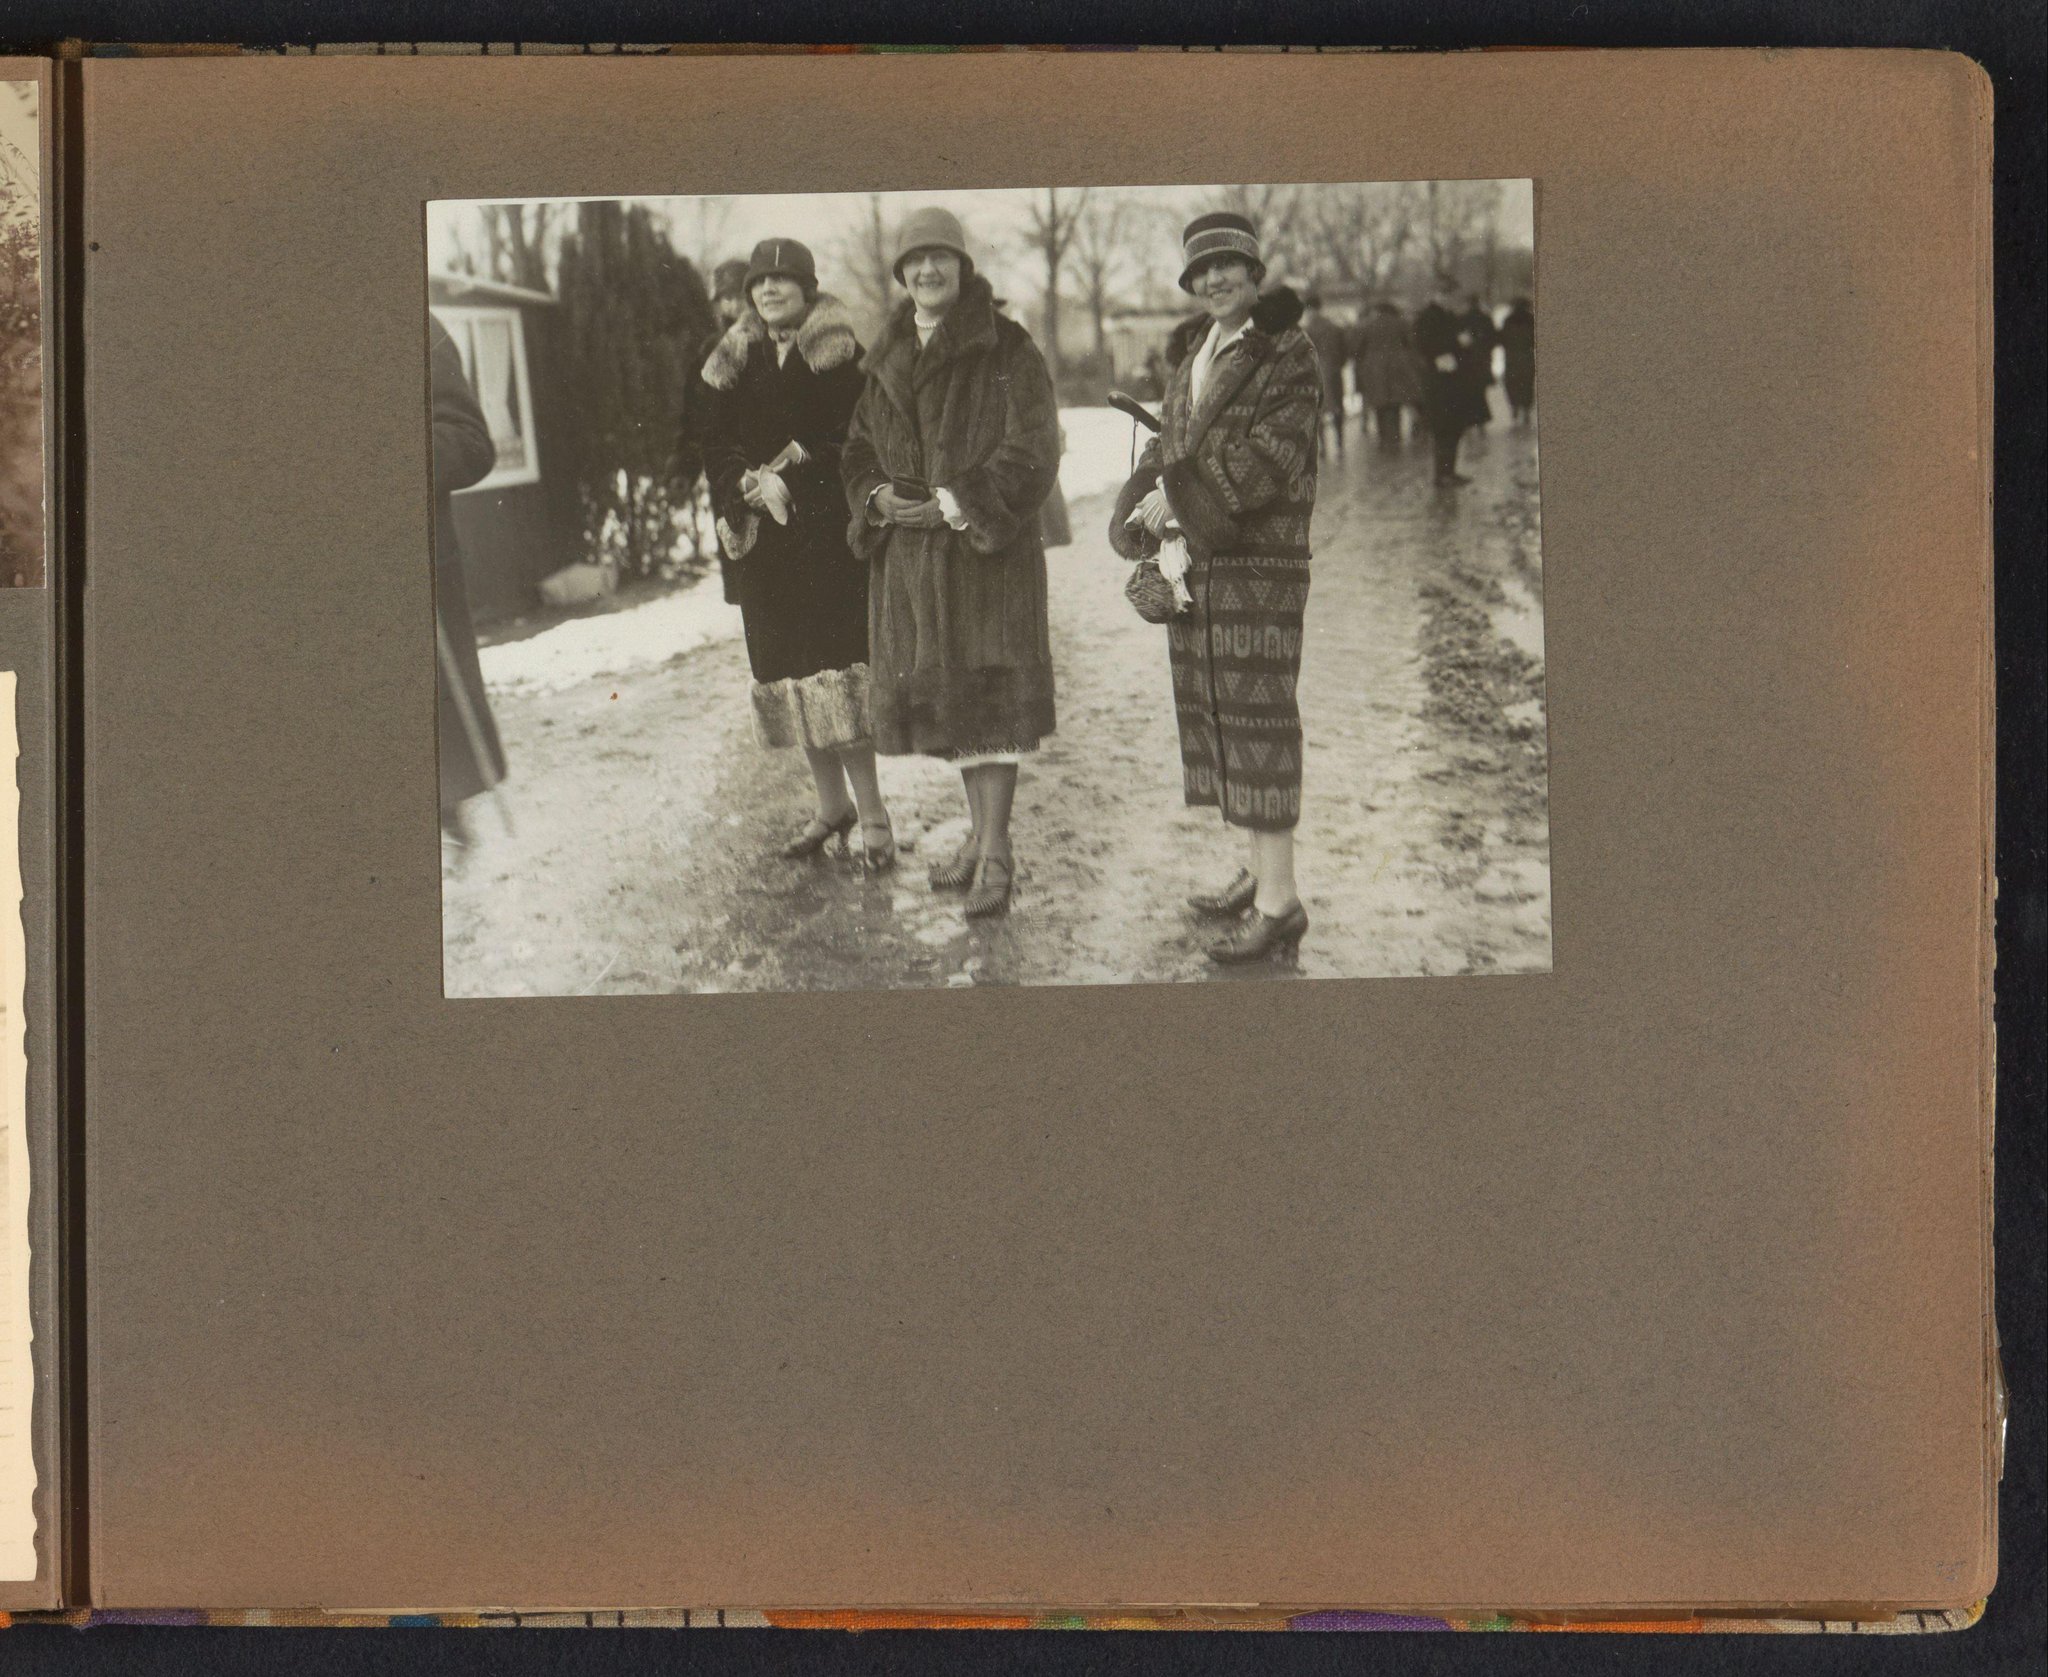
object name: album leaf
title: Drie vrouwen in winterjassen op een modderpad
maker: Anonymous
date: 1900-1925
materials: cardboard, photographic support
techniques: gelatin silver print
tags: adult woman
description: Onderdeel van Fotoalbum van een onbekende Nederlandse familie met connecties in Suriname en Nederlands-Indië (2).